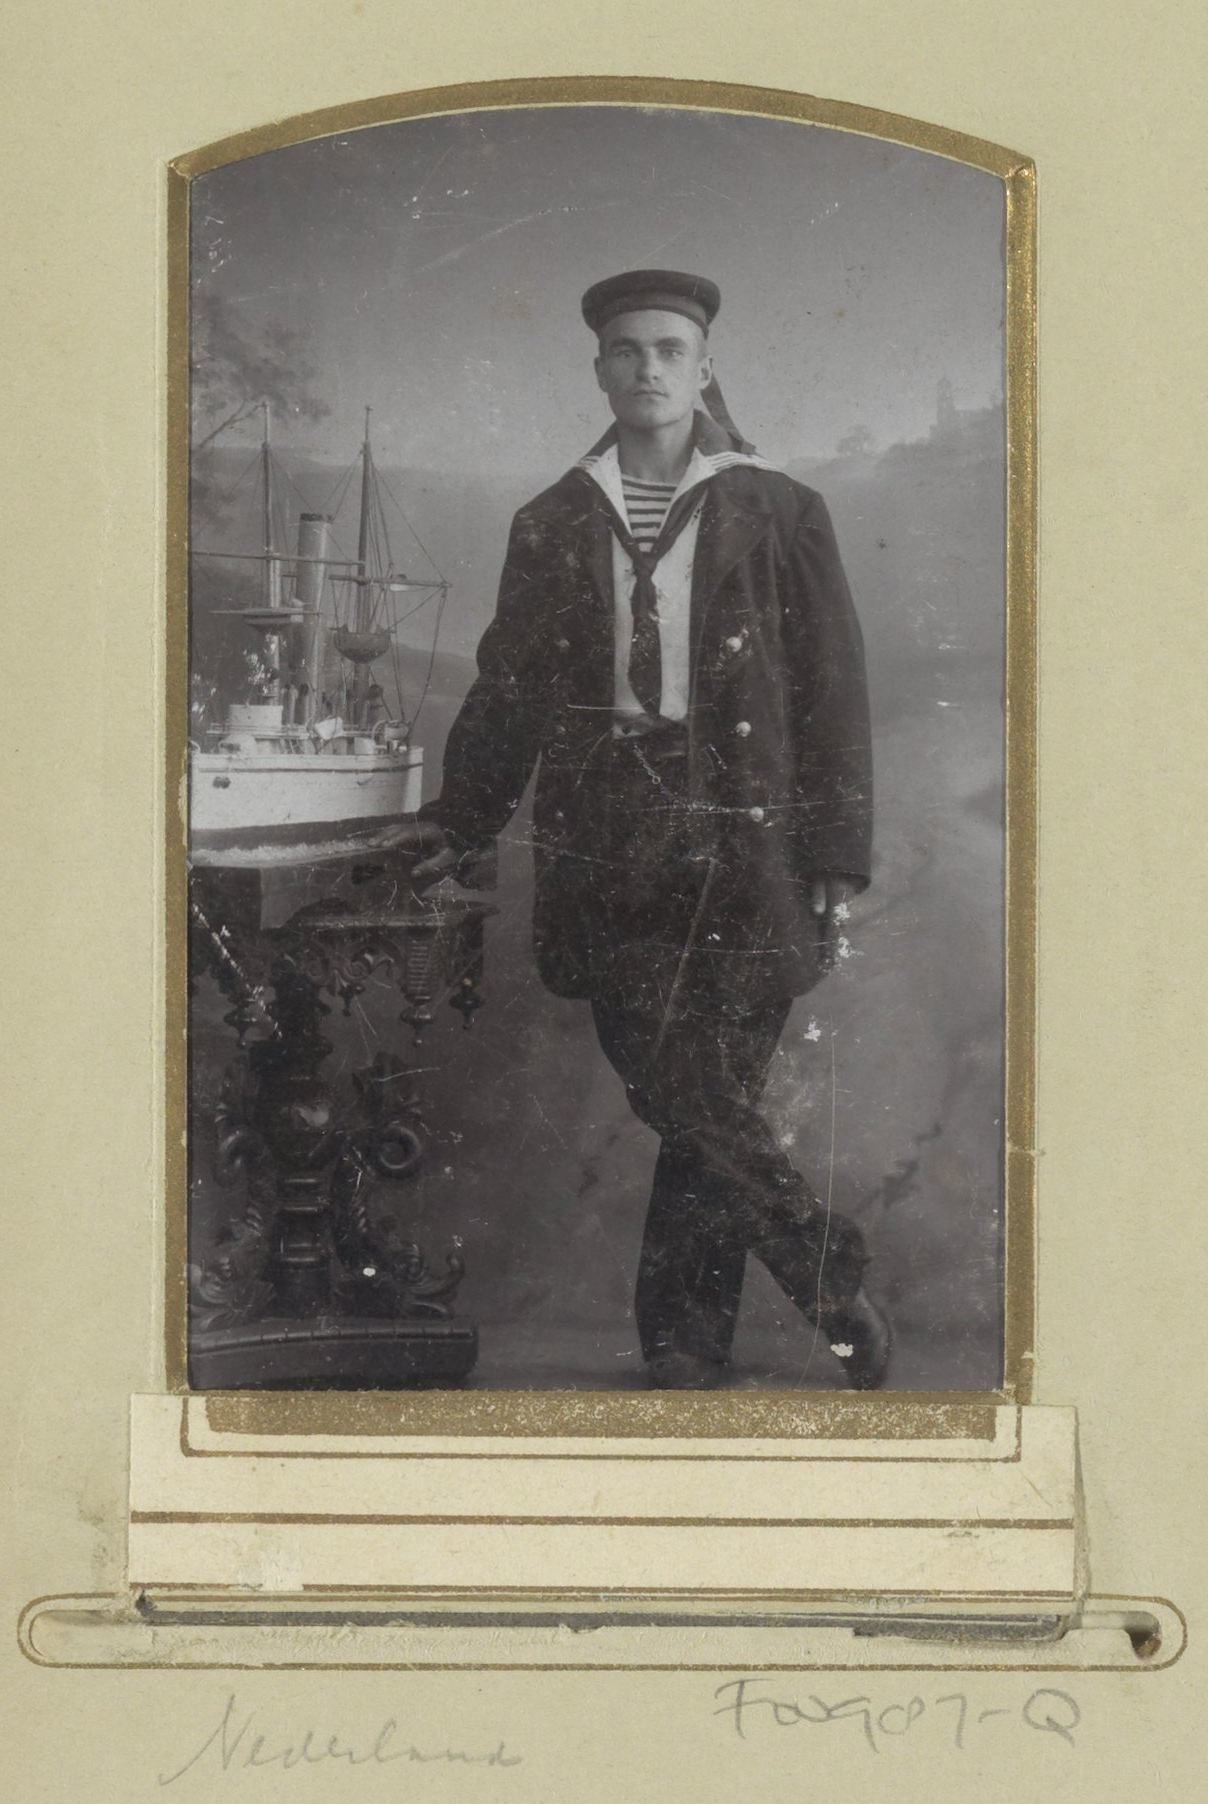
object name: carte de visite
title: Portret van een (vermoedelijk) Nederlandse matroos, staand bij een scheepsmodel op tafel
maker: Anonymous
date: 1870-1900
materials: cardboard, paper, photographic support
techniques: gelatin silver print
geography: netherlands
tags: studio requisites ~ photographer, navy, warfare; military affairs, (military) uniforms, division of armed forces, ship-model, netherlands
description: Onderdeel van Album met cartes-de-visite en kabinetfoto's van militairen in uniform.